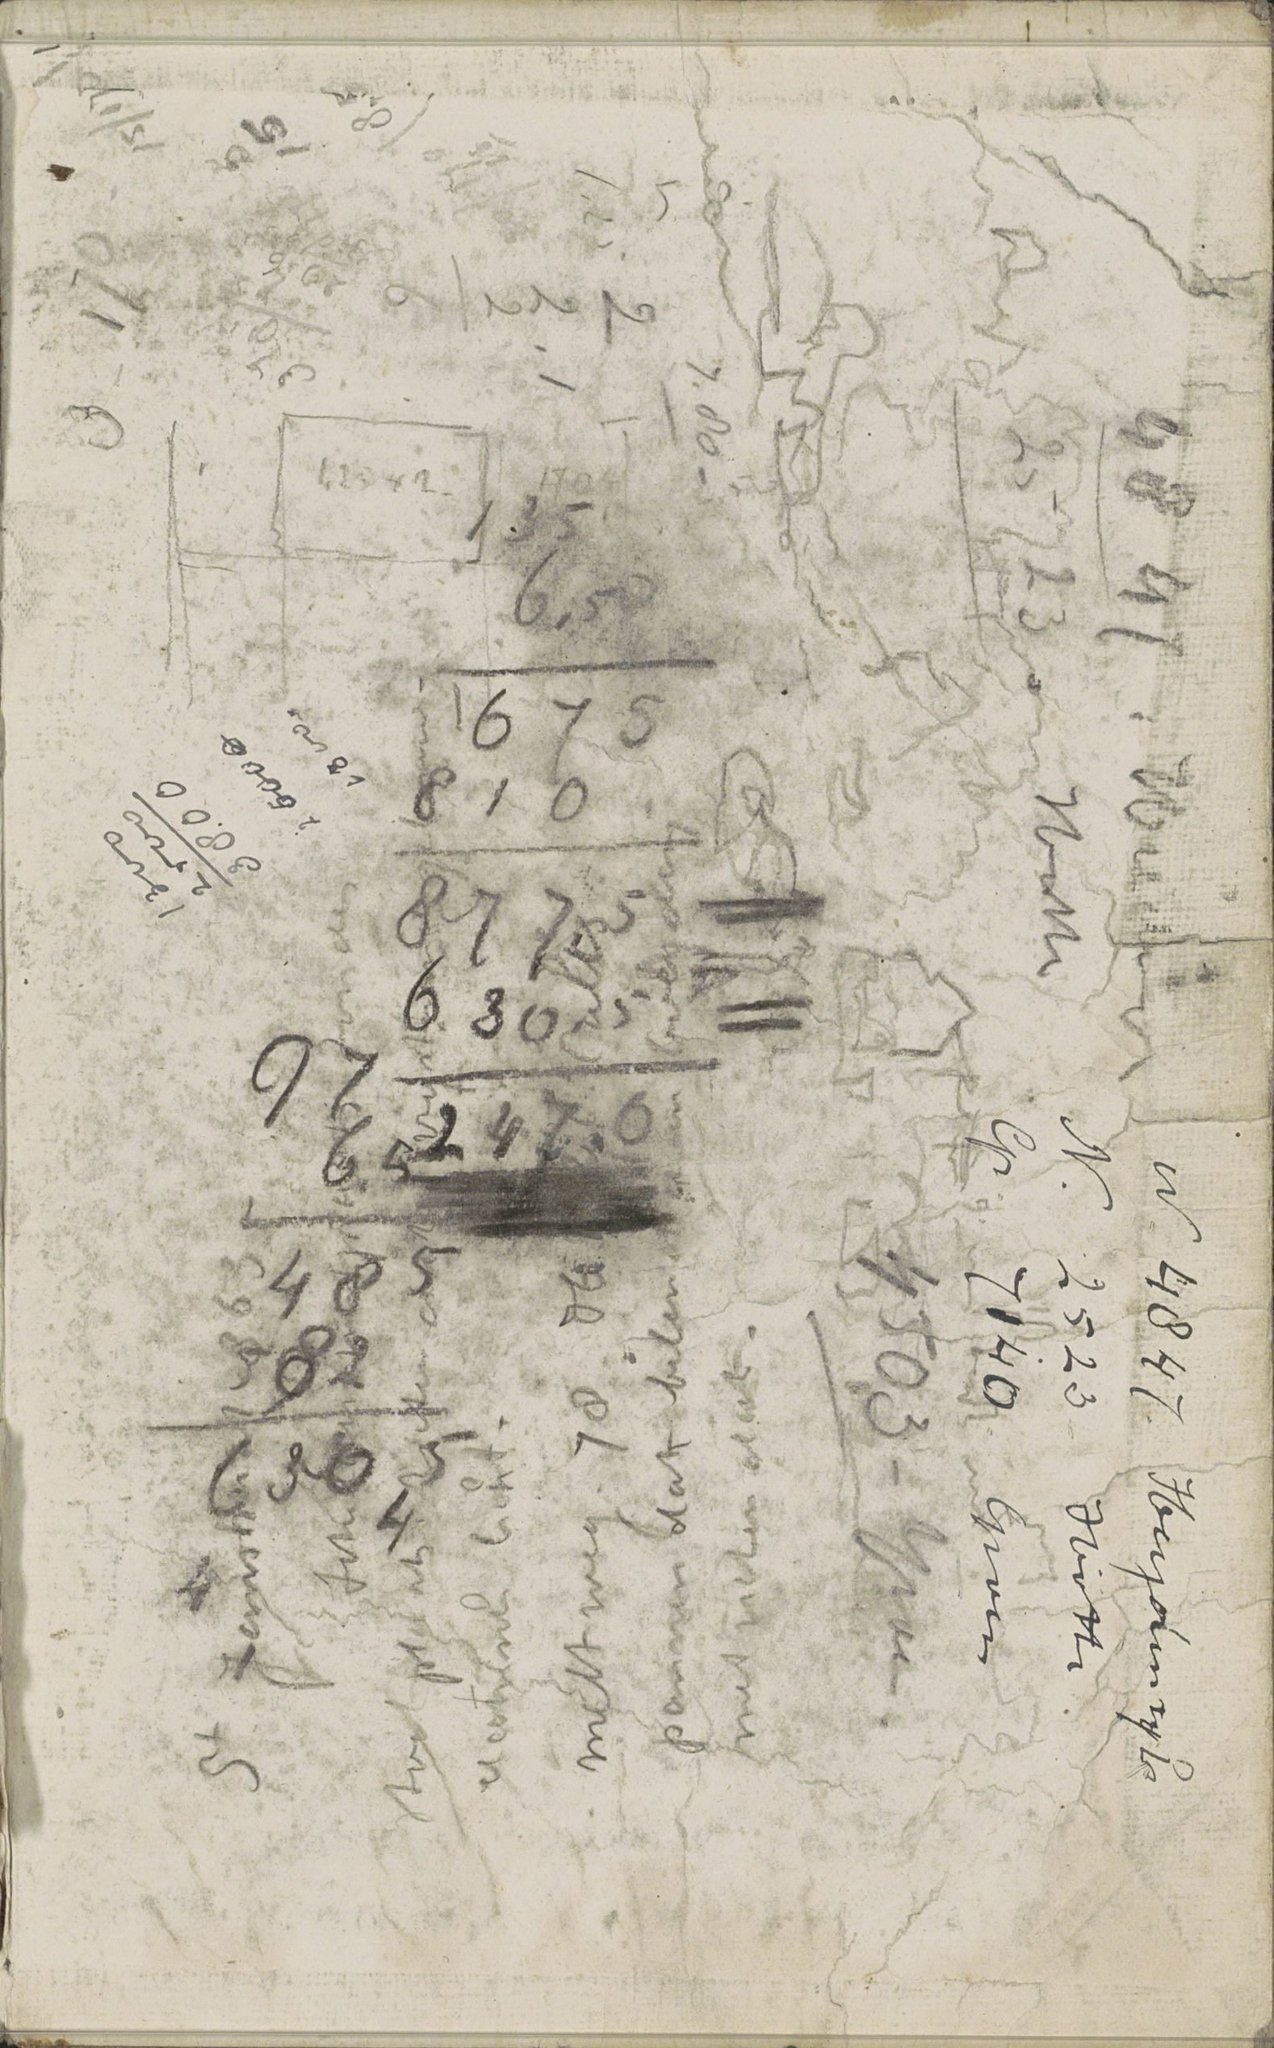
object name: sketchbook leaf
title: Landschap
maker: cornelis vreedenburgh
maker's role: draughtsman, print maker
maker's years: 1880-1946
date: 1890-1946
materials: paper, pencil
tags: landscapes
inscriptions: annotation: ‘[...]’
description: Tevens een deel van een plattegrond. Achterste schutblad uit een schetsboek met 45 bladen.